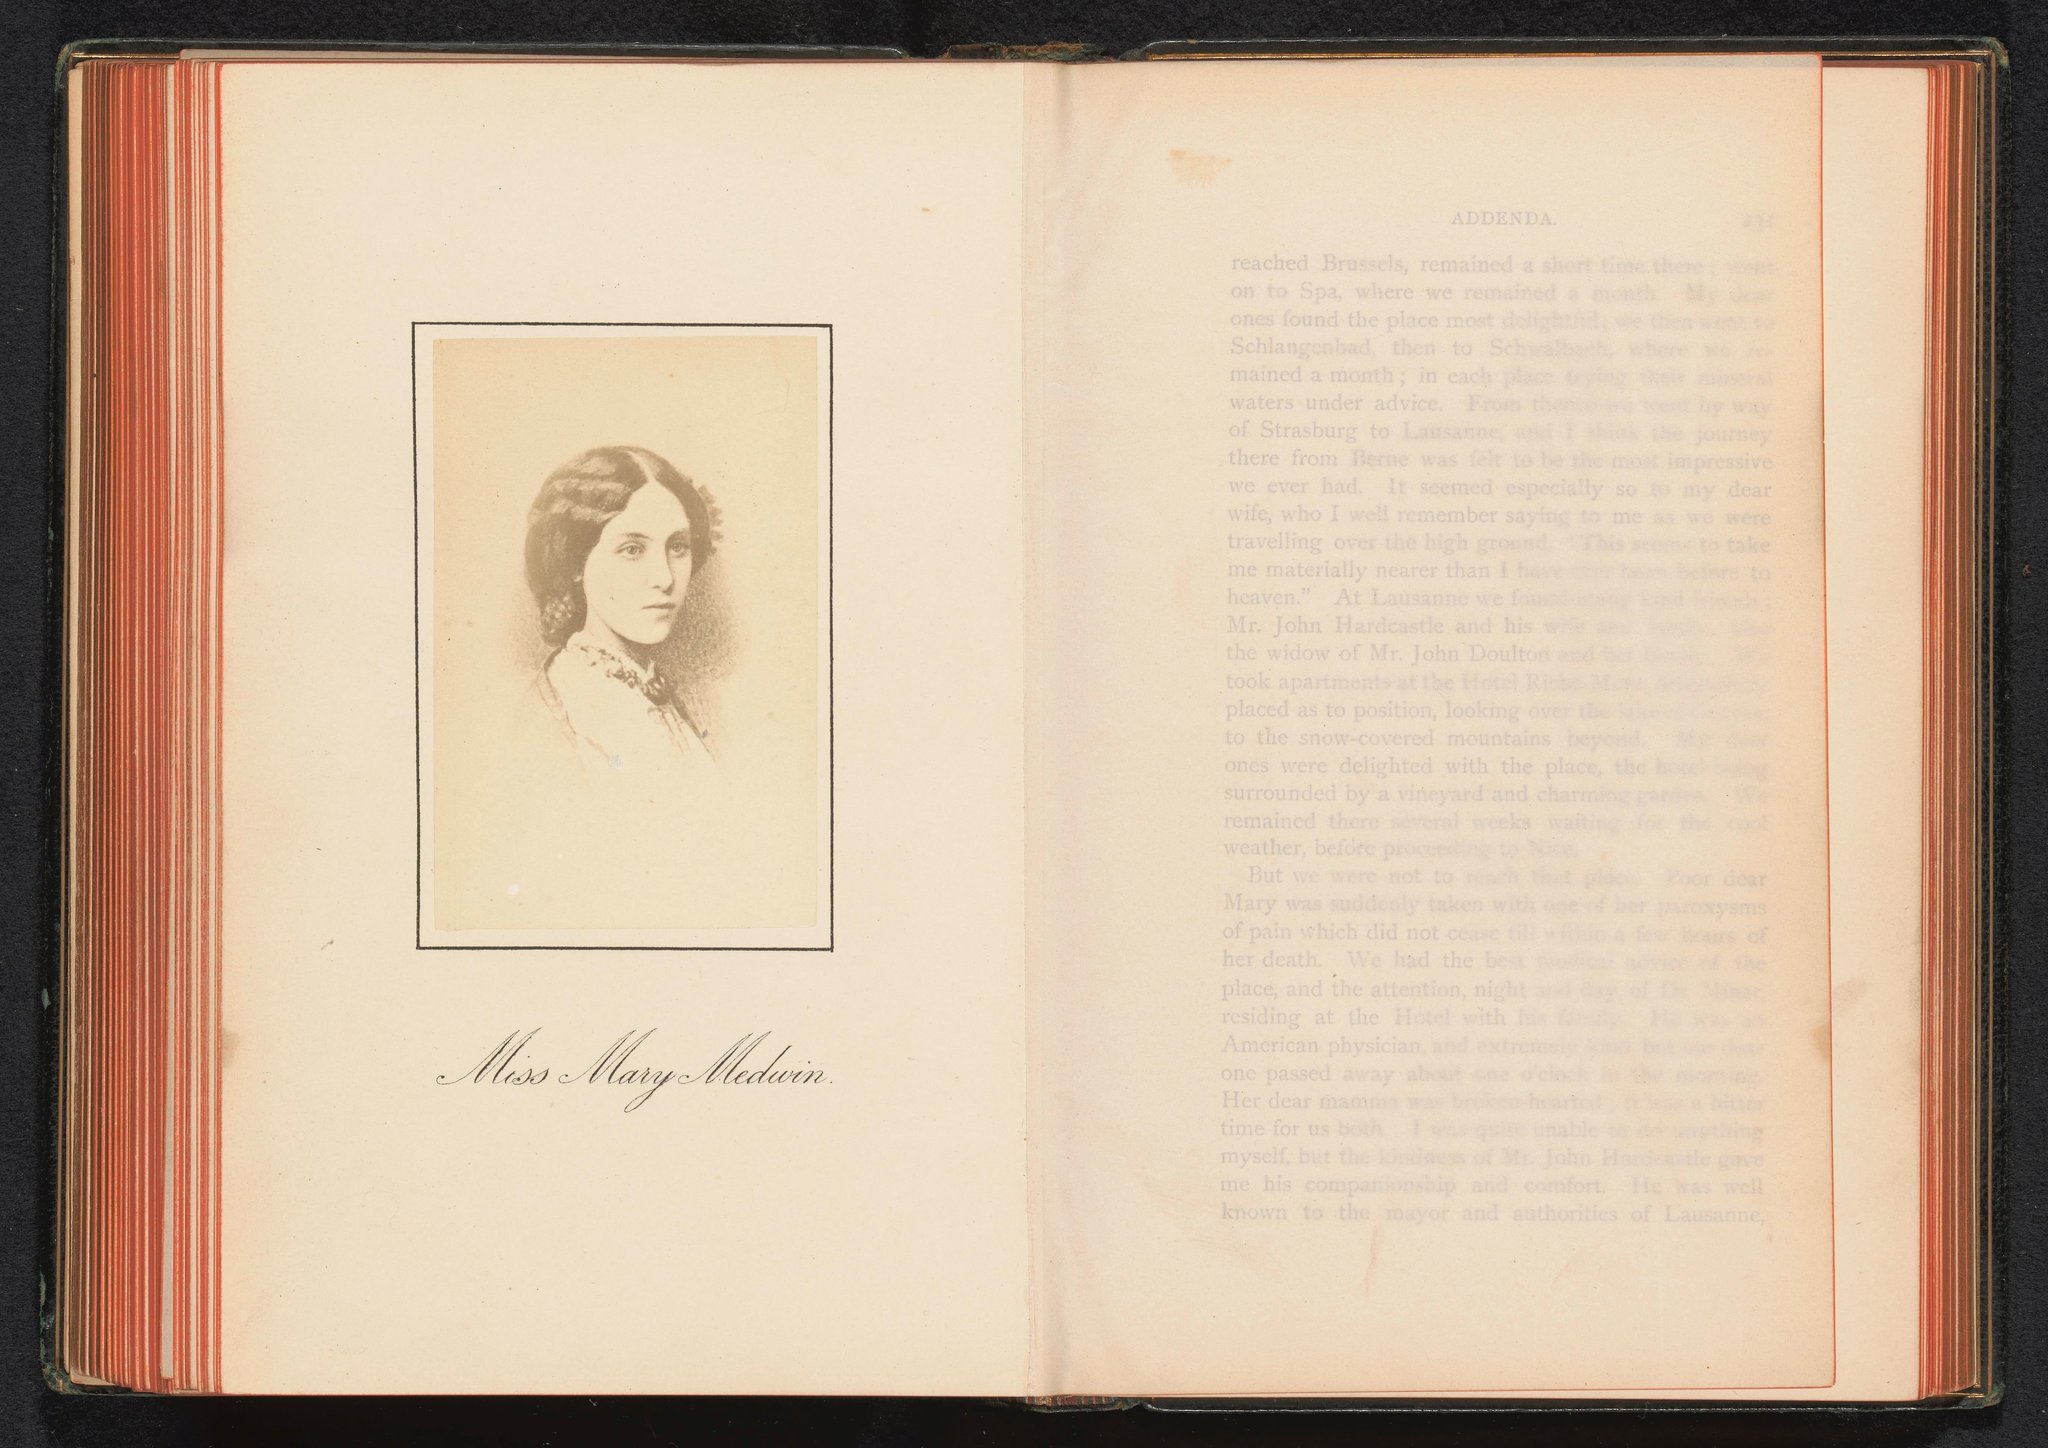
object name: photograph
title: Miss Mary Medwin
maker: j. perry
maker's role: fotograaf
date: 1872-1882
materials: photographic support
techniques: albumen print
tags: historical persons - bb - woman